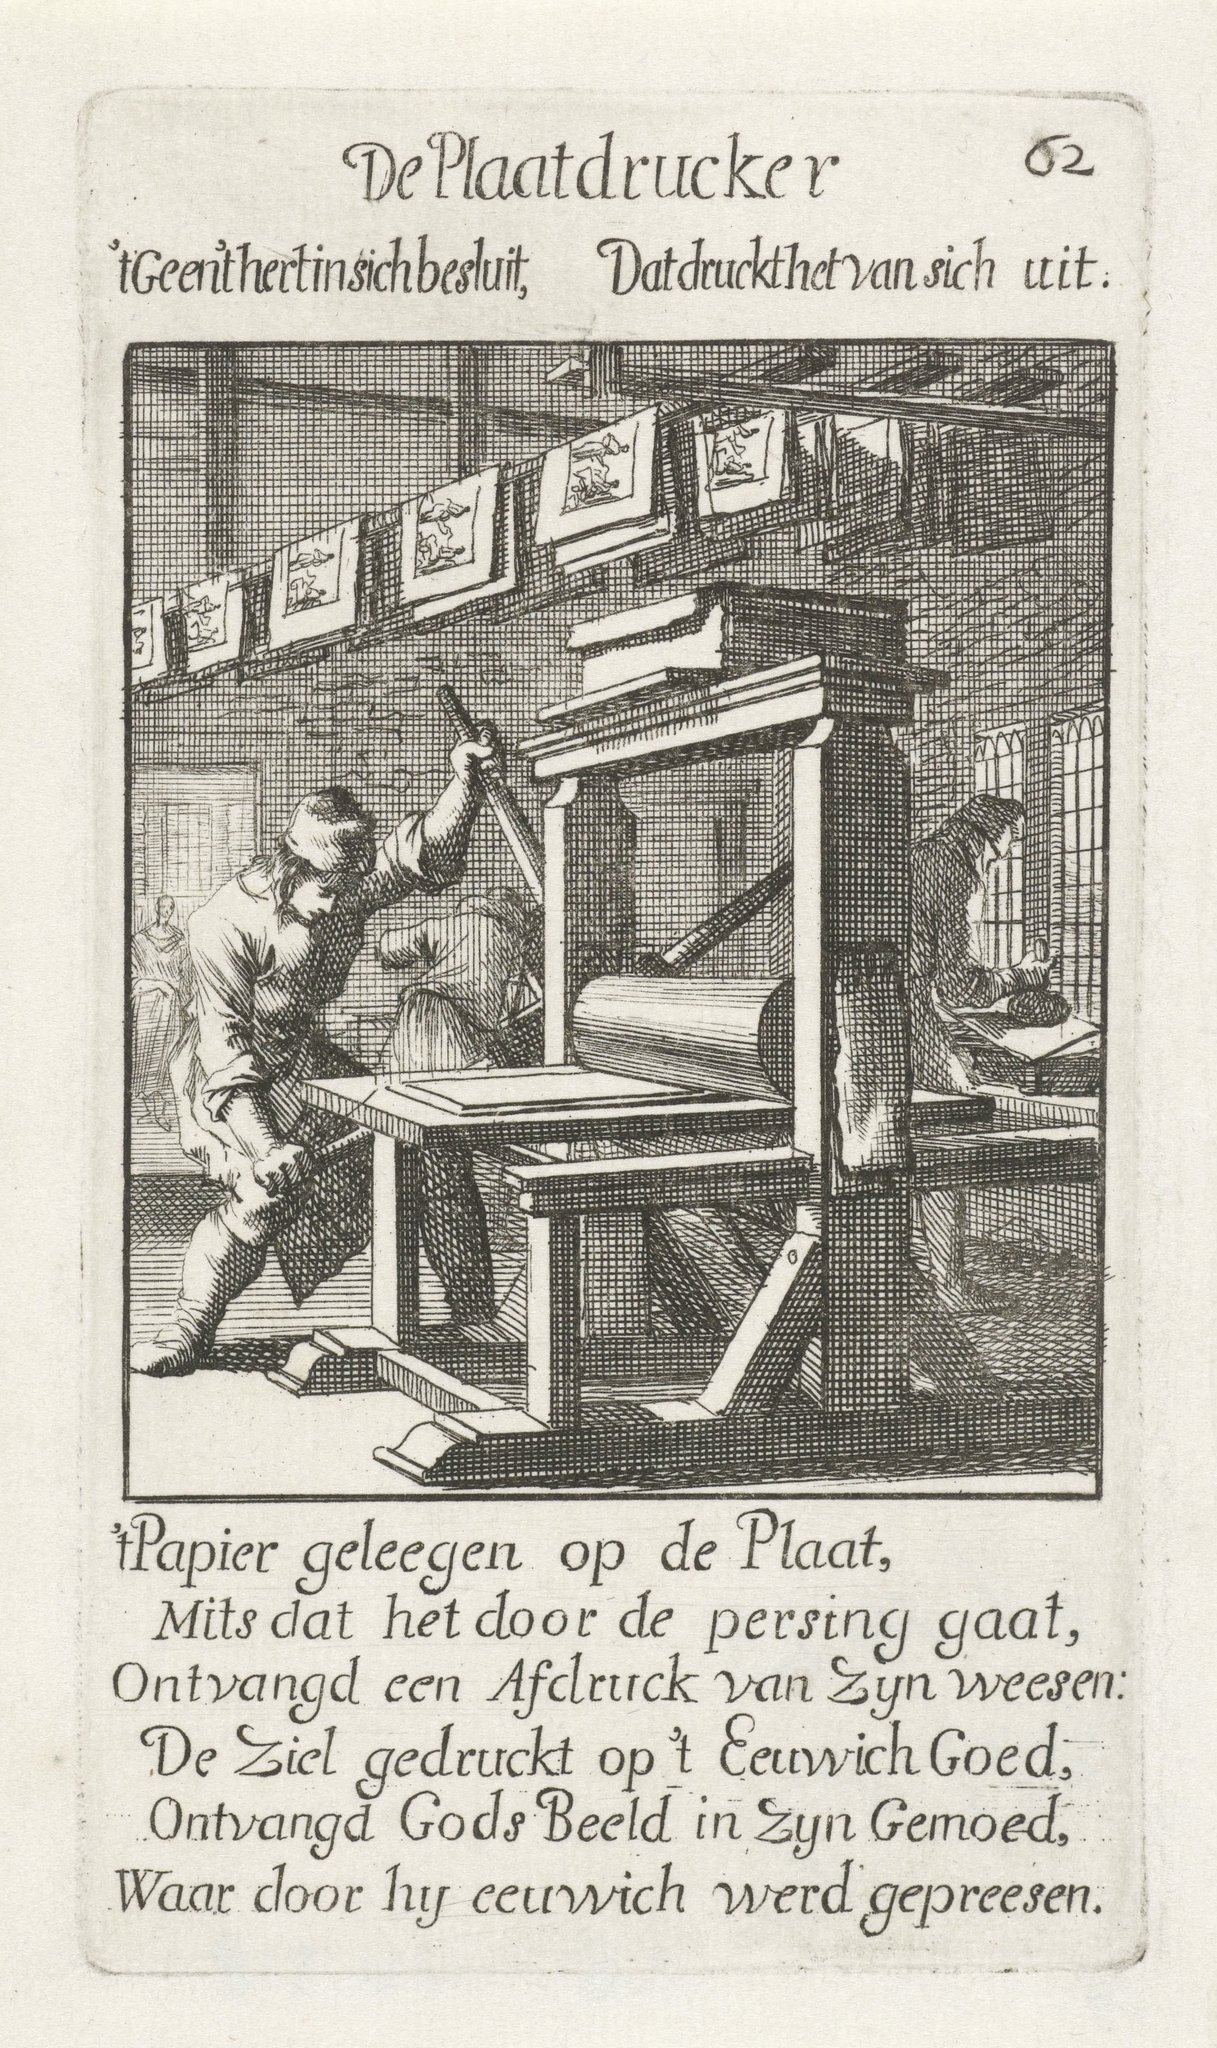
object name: print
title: De Plaatdrucker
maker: jan luyken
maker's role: draughtsman, print maker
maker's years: 1649-1712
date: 1694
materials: paper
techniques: etching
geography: amsterdam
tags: handicrafts, craftsman at work, printing press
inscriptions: collector's mark: Lugt 2228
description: Maakt deel uit van de 100-delige serie beroepsprenten van Jan en Caspar Luyken, getiteld: Het menselyk bedryf. S.l.s.n., 1694 (eerste druk).